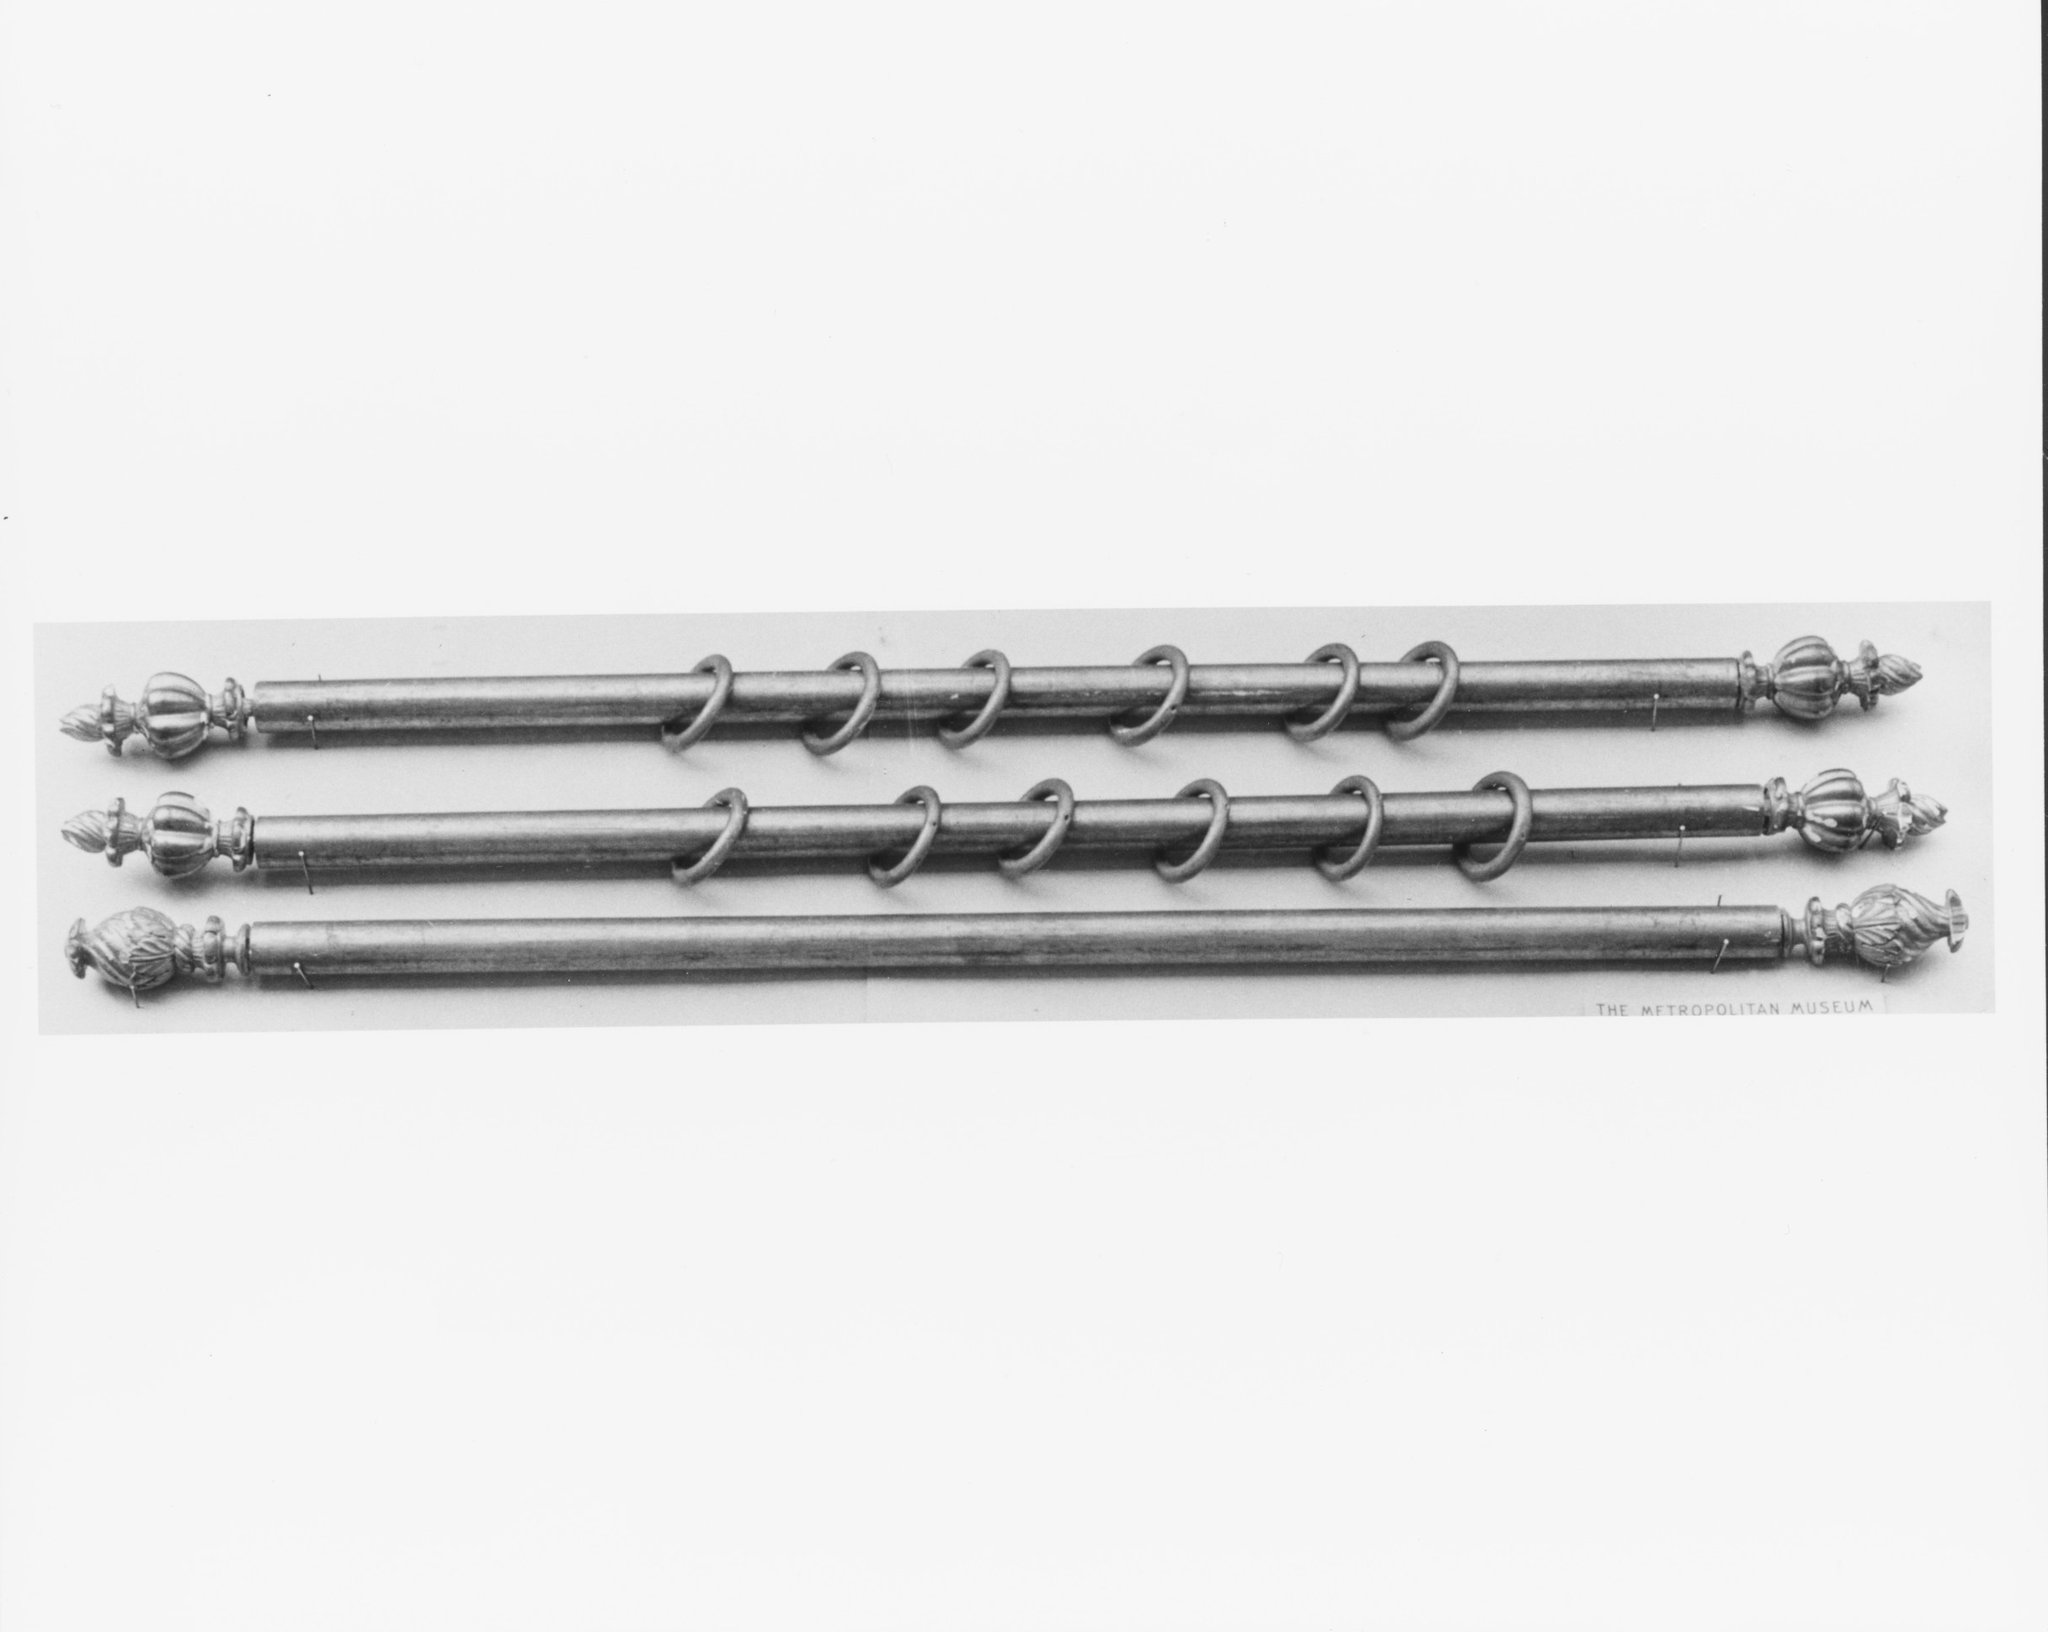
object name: curtain pole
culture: american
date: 1770-1800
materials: plaster, wood